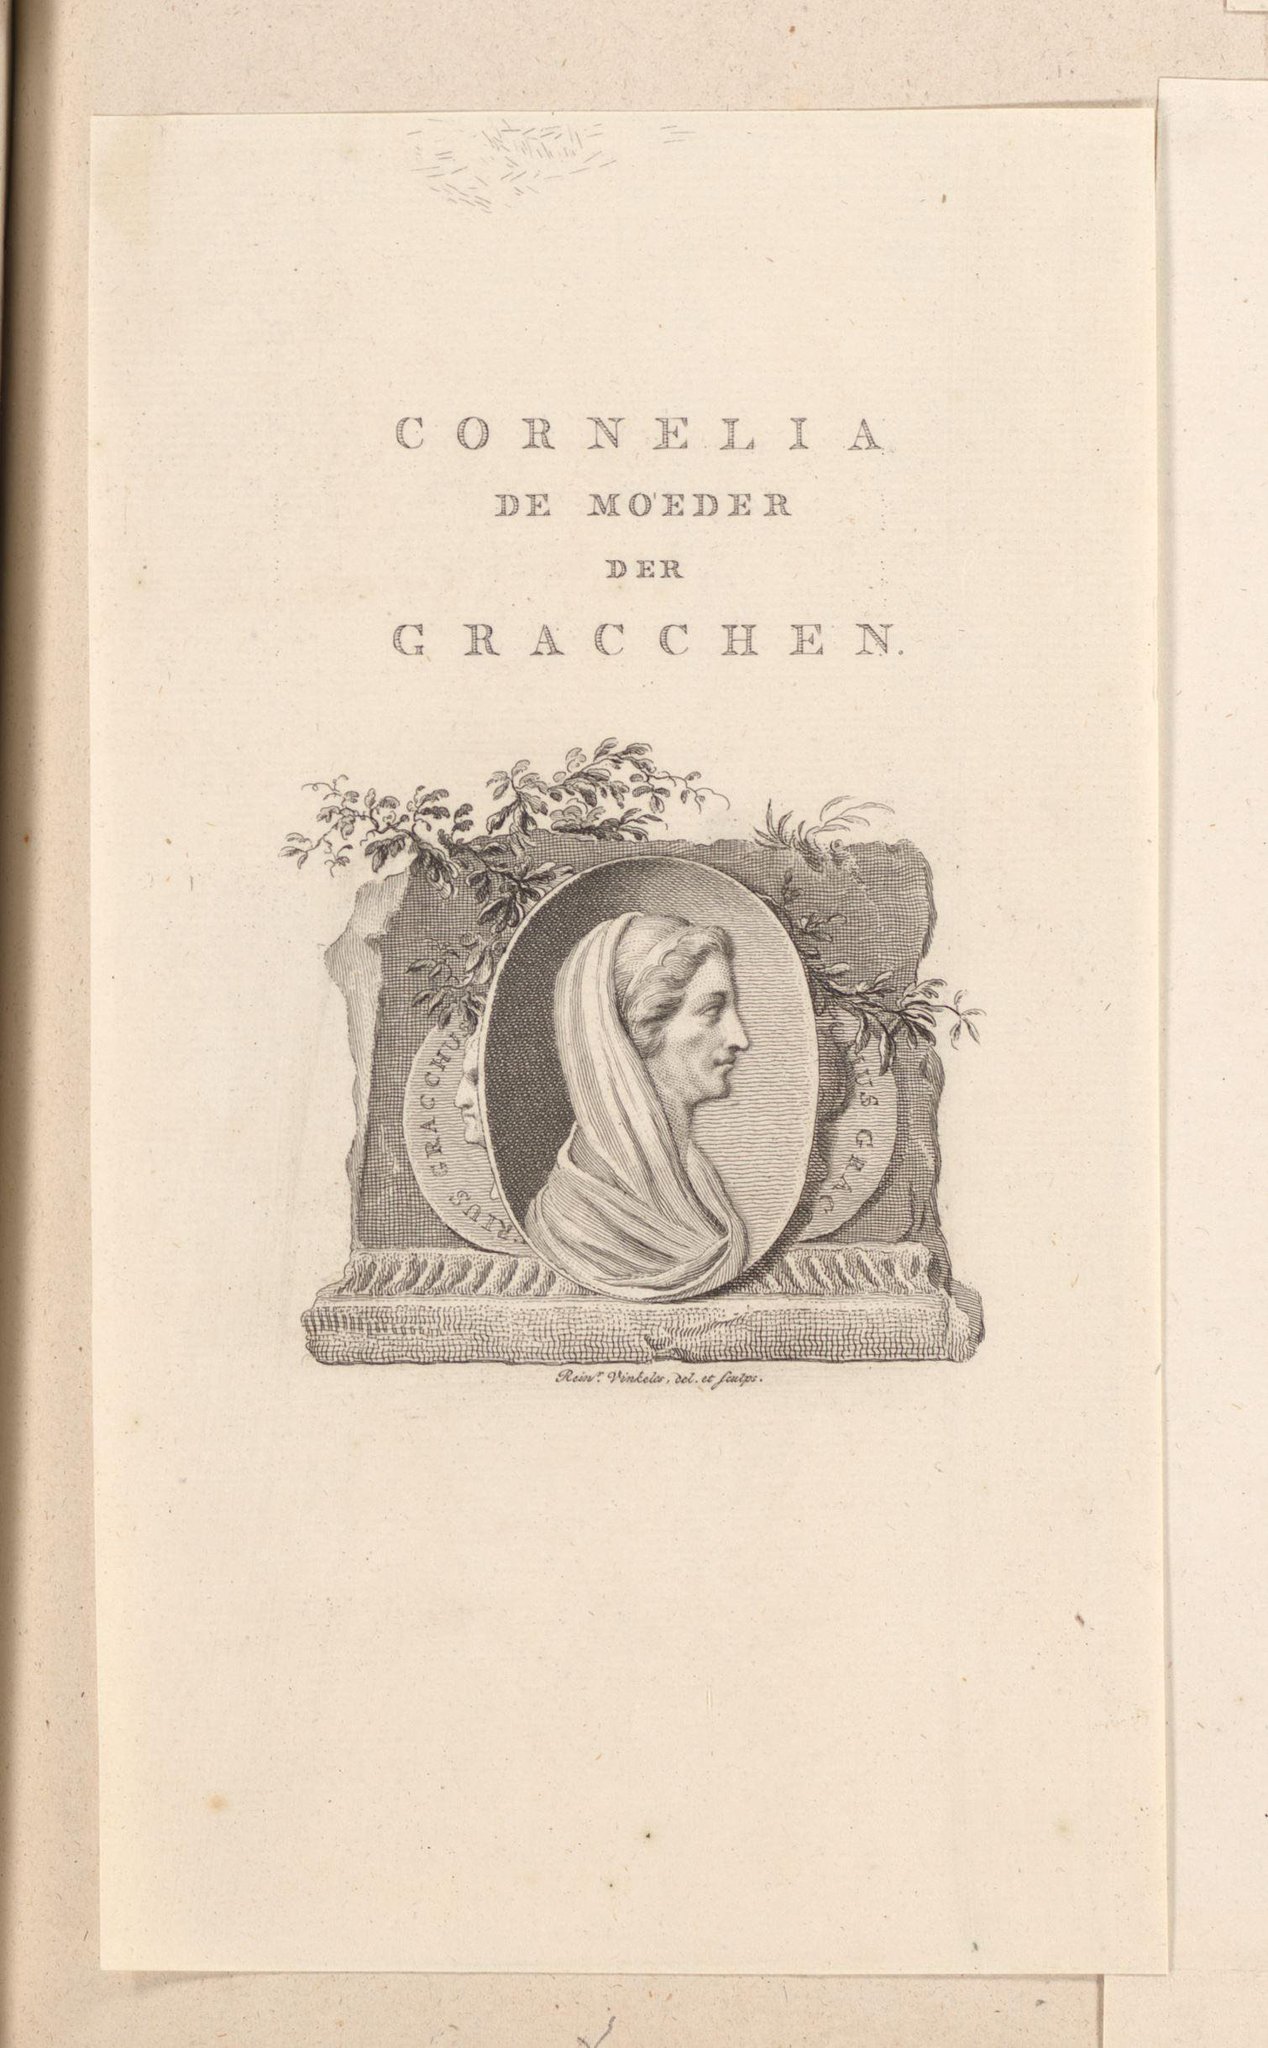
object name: album leaf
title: Medaillon met het portret van Cornelia, moeder der Gracchen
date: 1798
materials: paper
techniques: engraving, etching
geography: amsterdam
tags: (story of) gaius sempronius gracchus, (story of) tiberius sempronius gracchus, (story of) cornelia, mother of the gracchi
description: Steen met een medaillon. Daarop het portret van Cornelia, moeder der Gracchen. De portretten van de broers Gaius en Tiberius Gracchus zijn deels achter het portret van de vrouw zichtbaar. De prent maakt deel uit van een album.